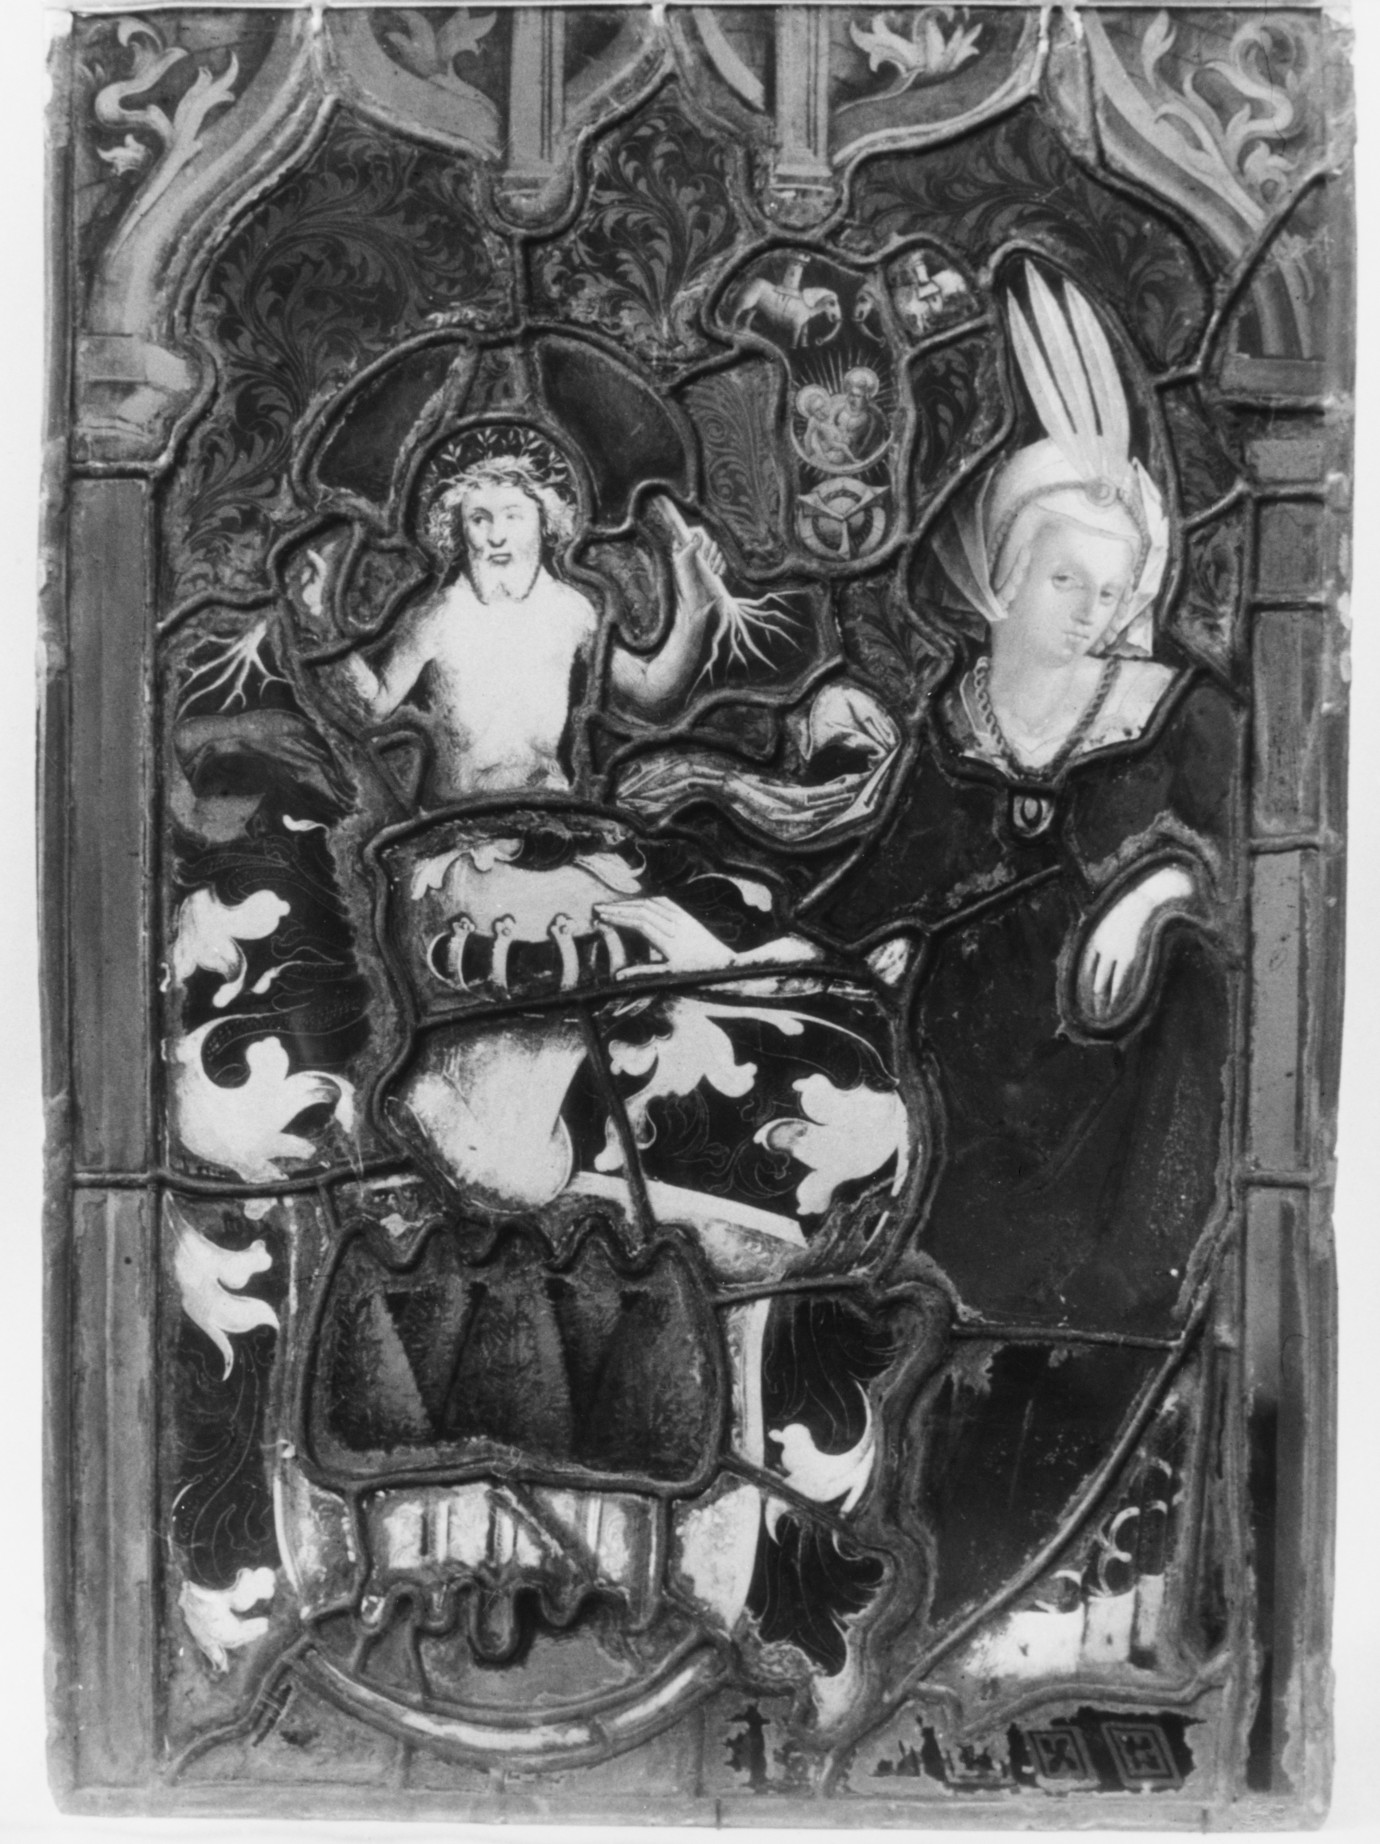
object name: panel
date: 1501-1600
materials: glass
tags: men,women